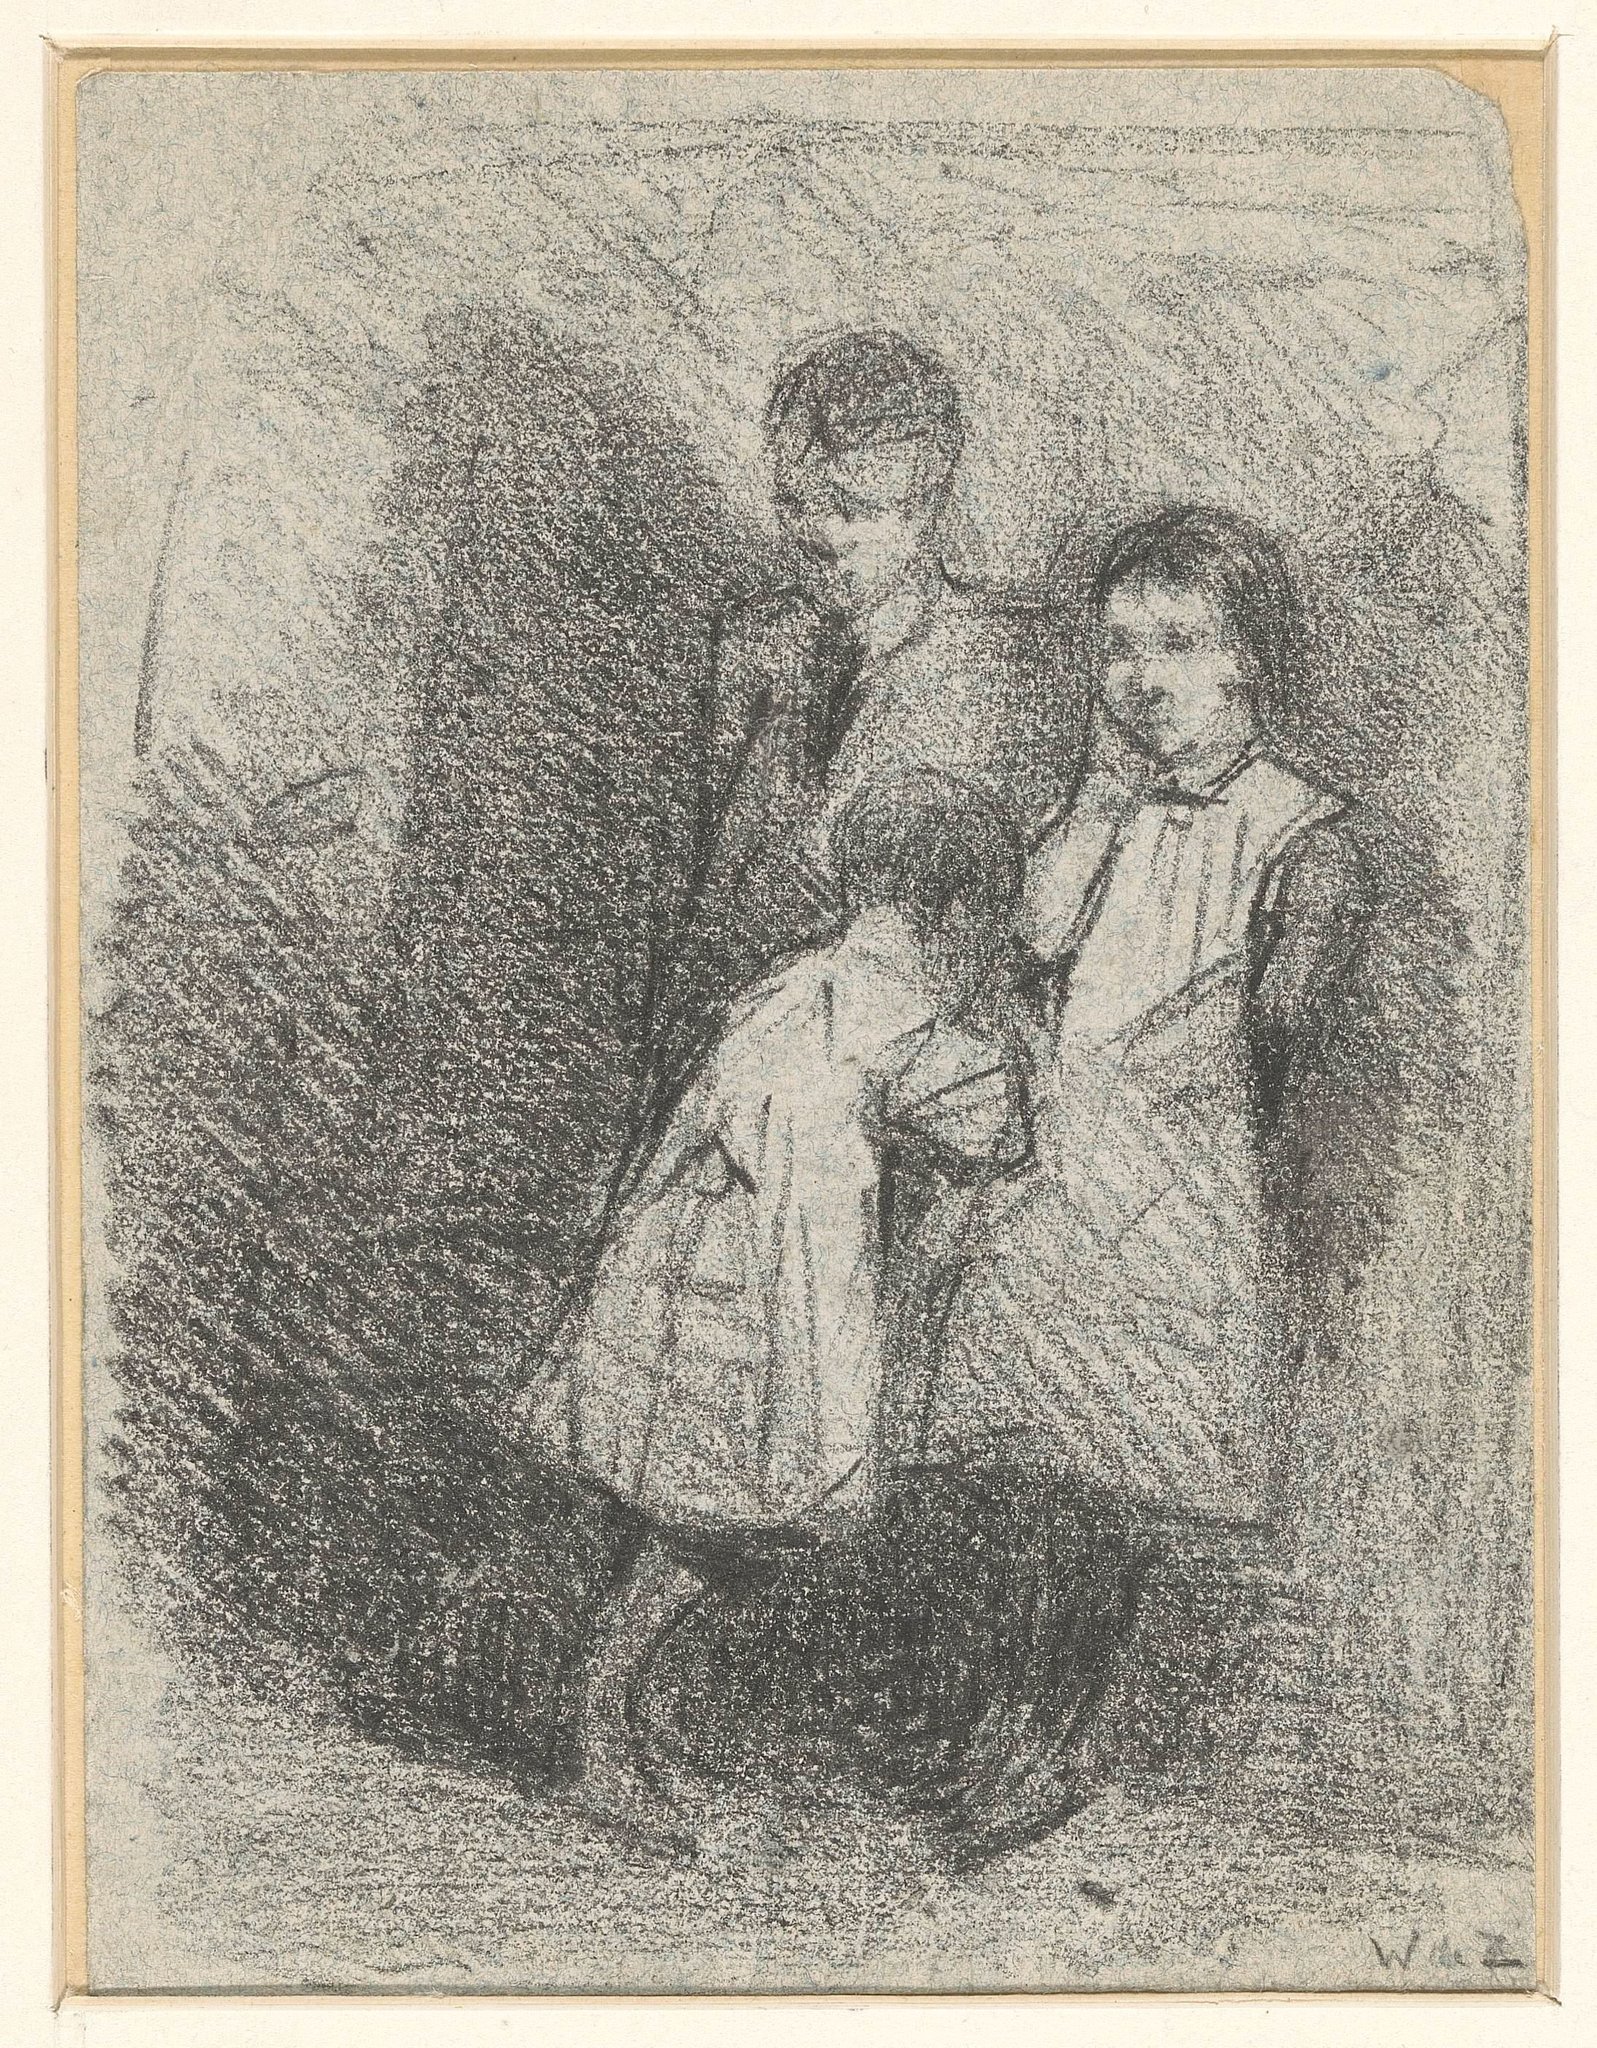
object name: drawing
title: Groepje van drie kinderen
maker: willem de zwart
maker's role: draughtsman, painter, print maker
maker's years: 1862-1931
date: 1872-1931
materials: chalk, paper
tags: child